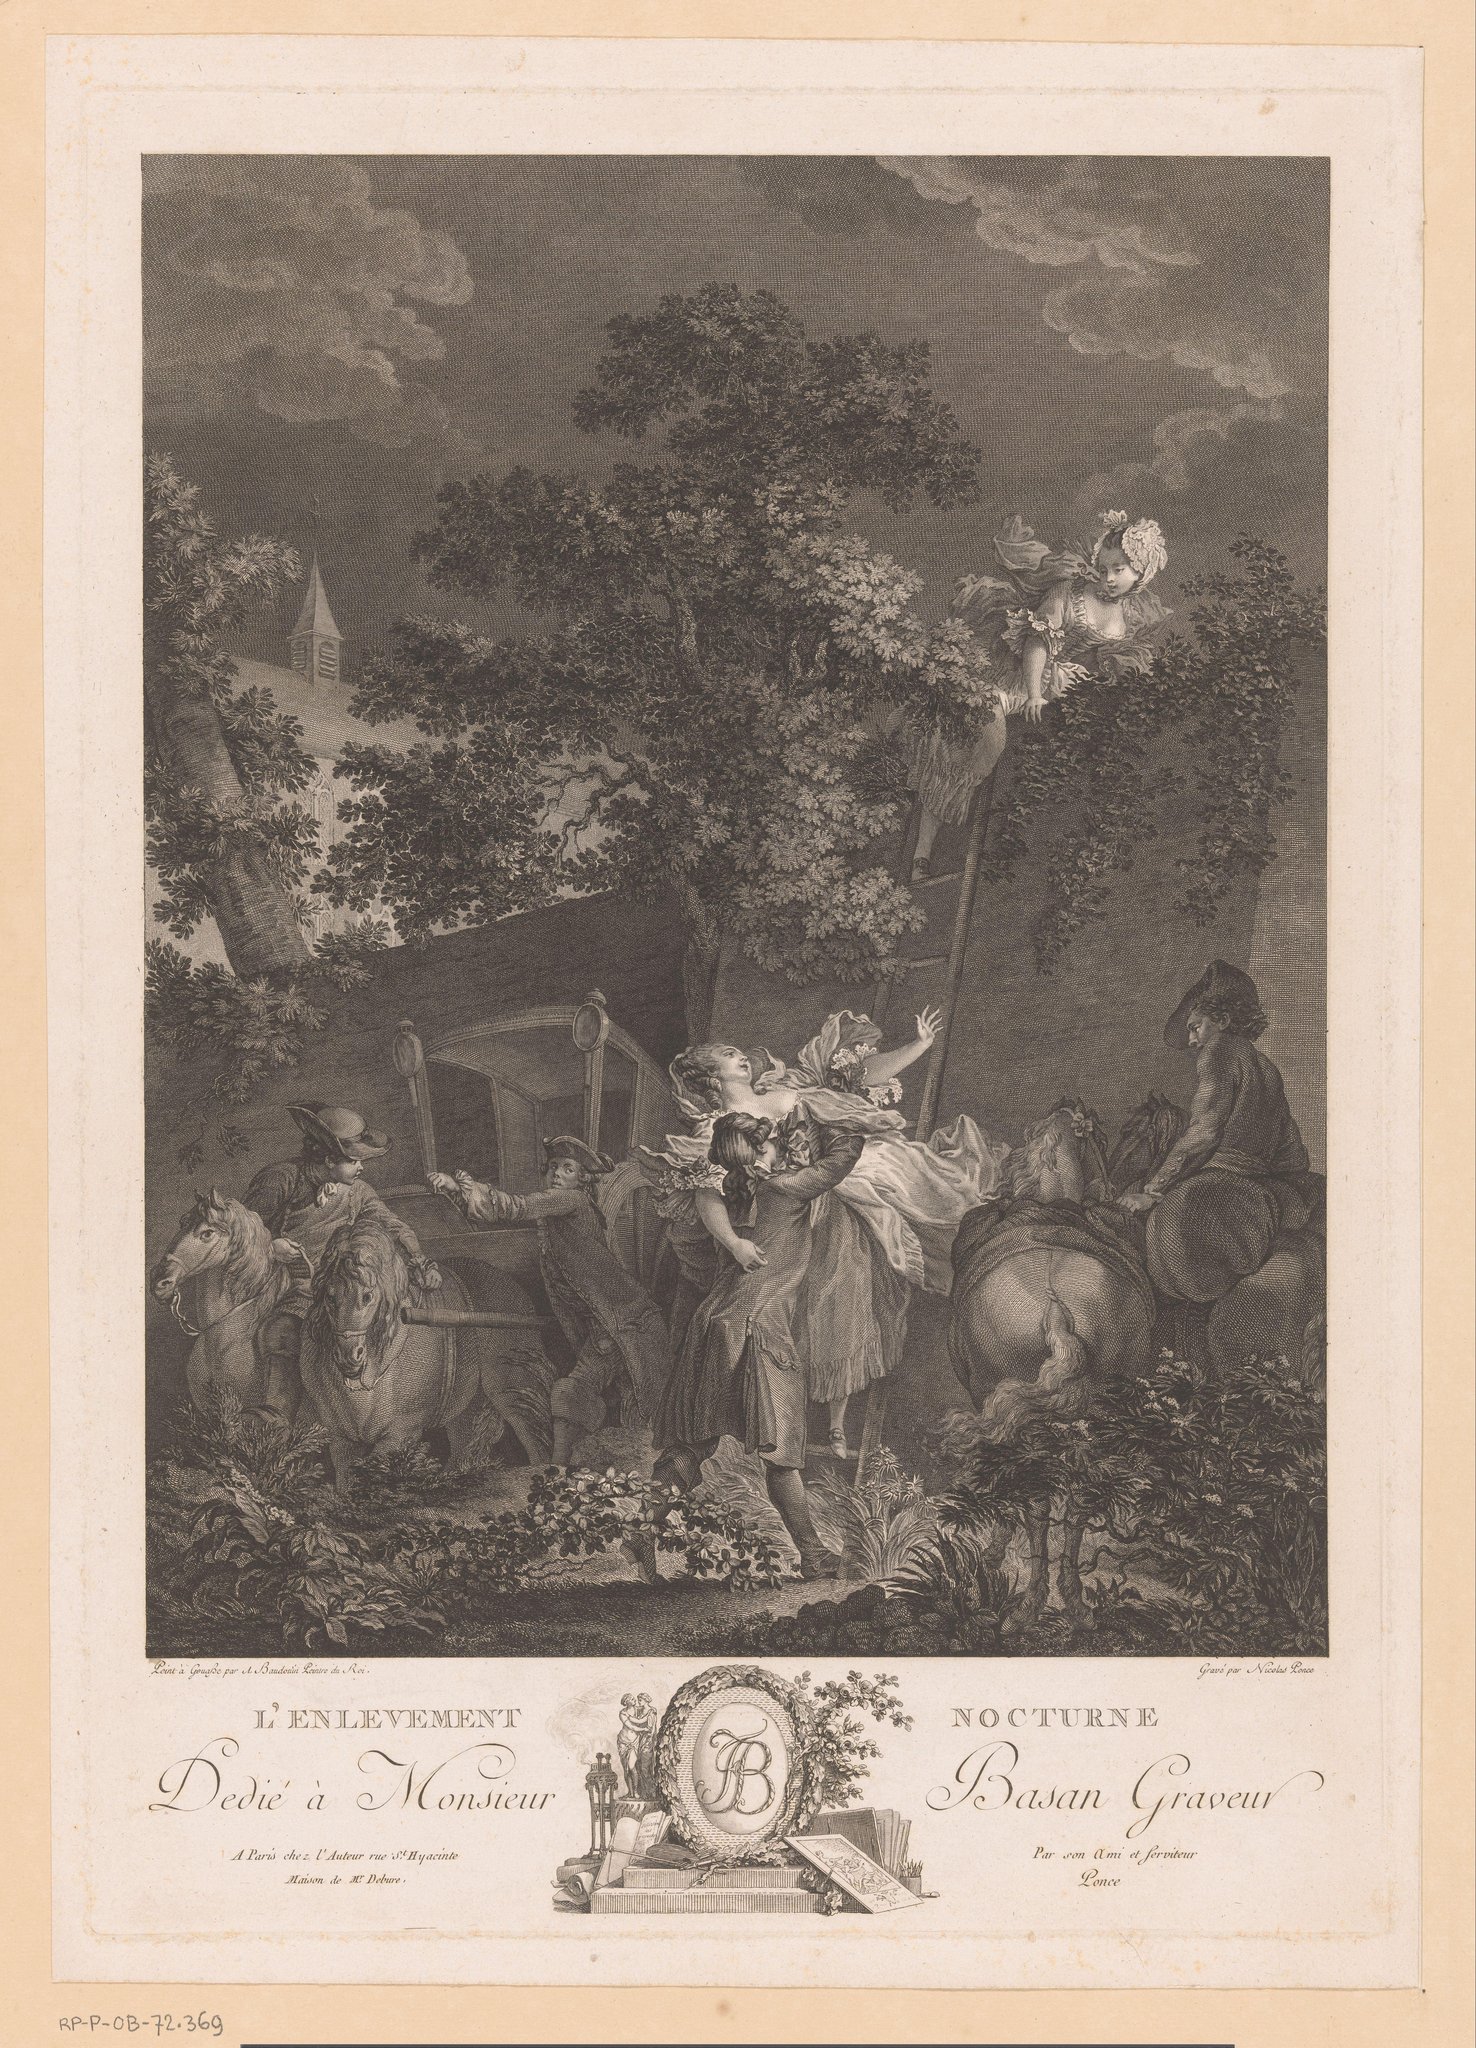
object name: print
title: Nachtelijk tafereel met twee dames die via een ladder over een kloostermuur ontsnappen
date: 1780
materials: paper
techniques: engraving, etching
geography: paris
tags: escape, escape attempts, lovers' meeting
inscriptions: collector's mark: Lugt 2233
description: Eén dame wordt beneden opgevangen door een man terwijl de andere bovenaan op de ladder stapt. Er staan bedienden en een paardenkoets op hen te wachten.